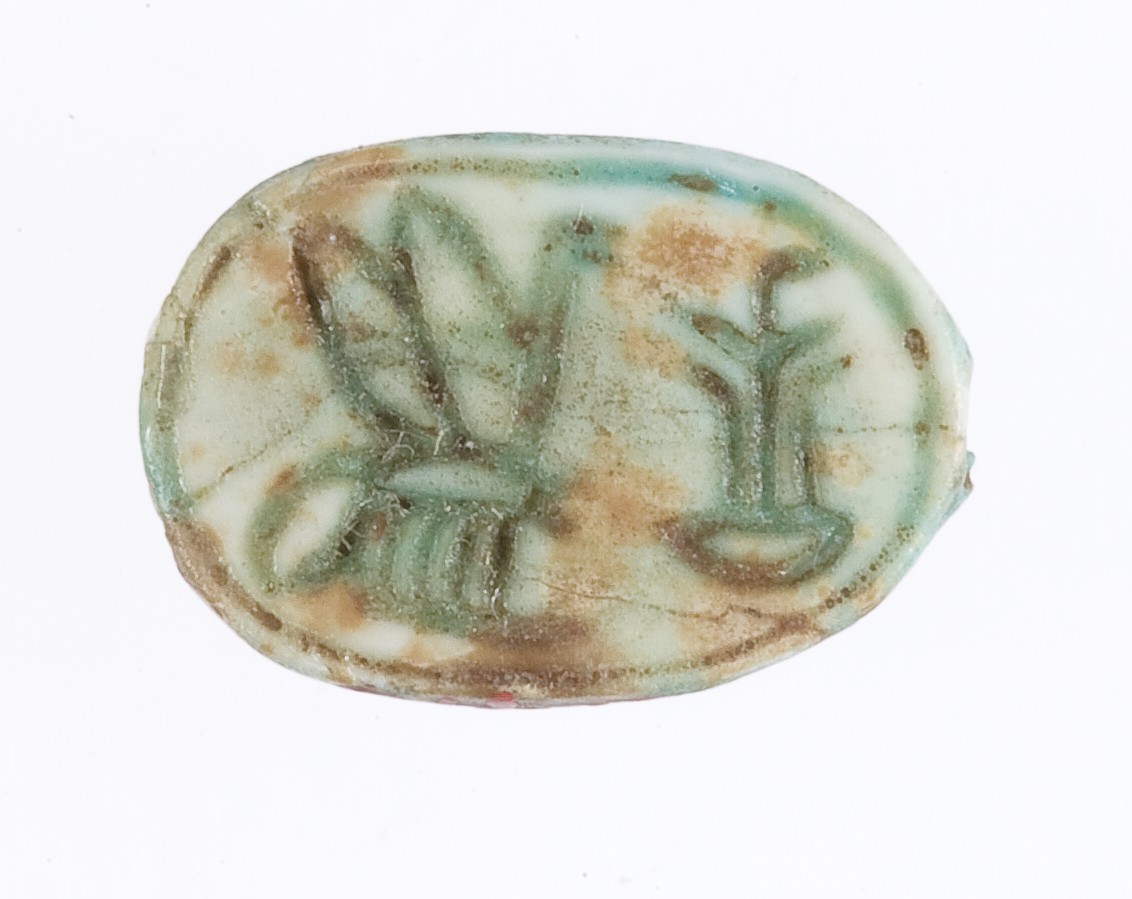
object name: scarab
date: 1640-1550 BCE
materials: stone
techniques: glazing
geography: egypt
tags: scarabs